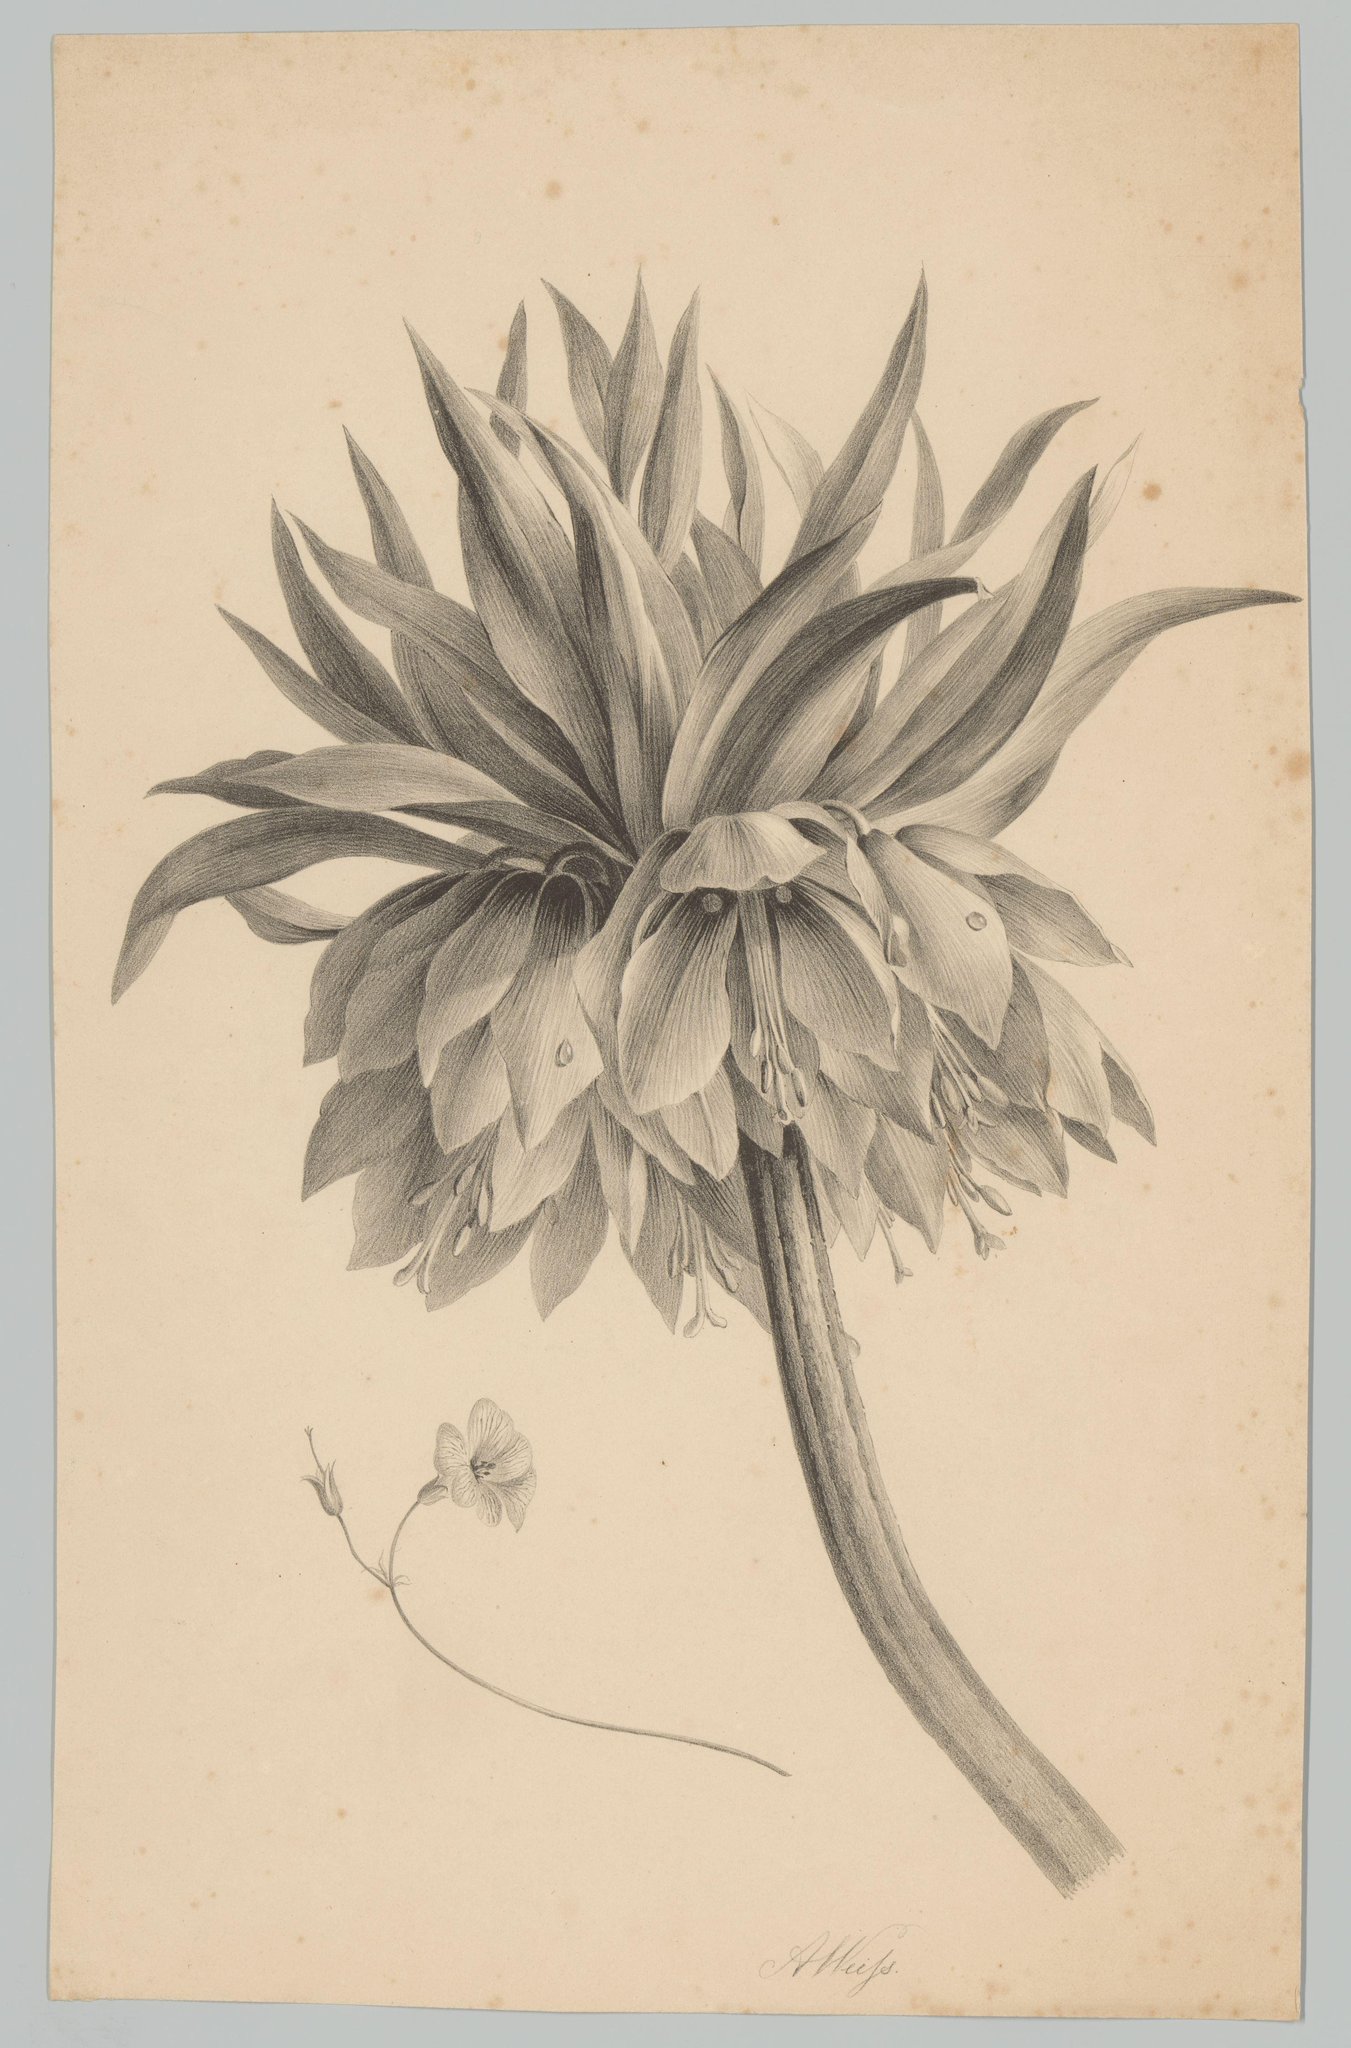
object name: print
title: Bloem op steel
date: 1820-1833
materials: paper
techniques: lithograph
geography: amsterdam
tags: flowers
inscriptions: collector's mark: Lugt 2228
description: Onderdeel van een omslag met in totaal zevenenzeventig lithografieën van bloemen en fruit.